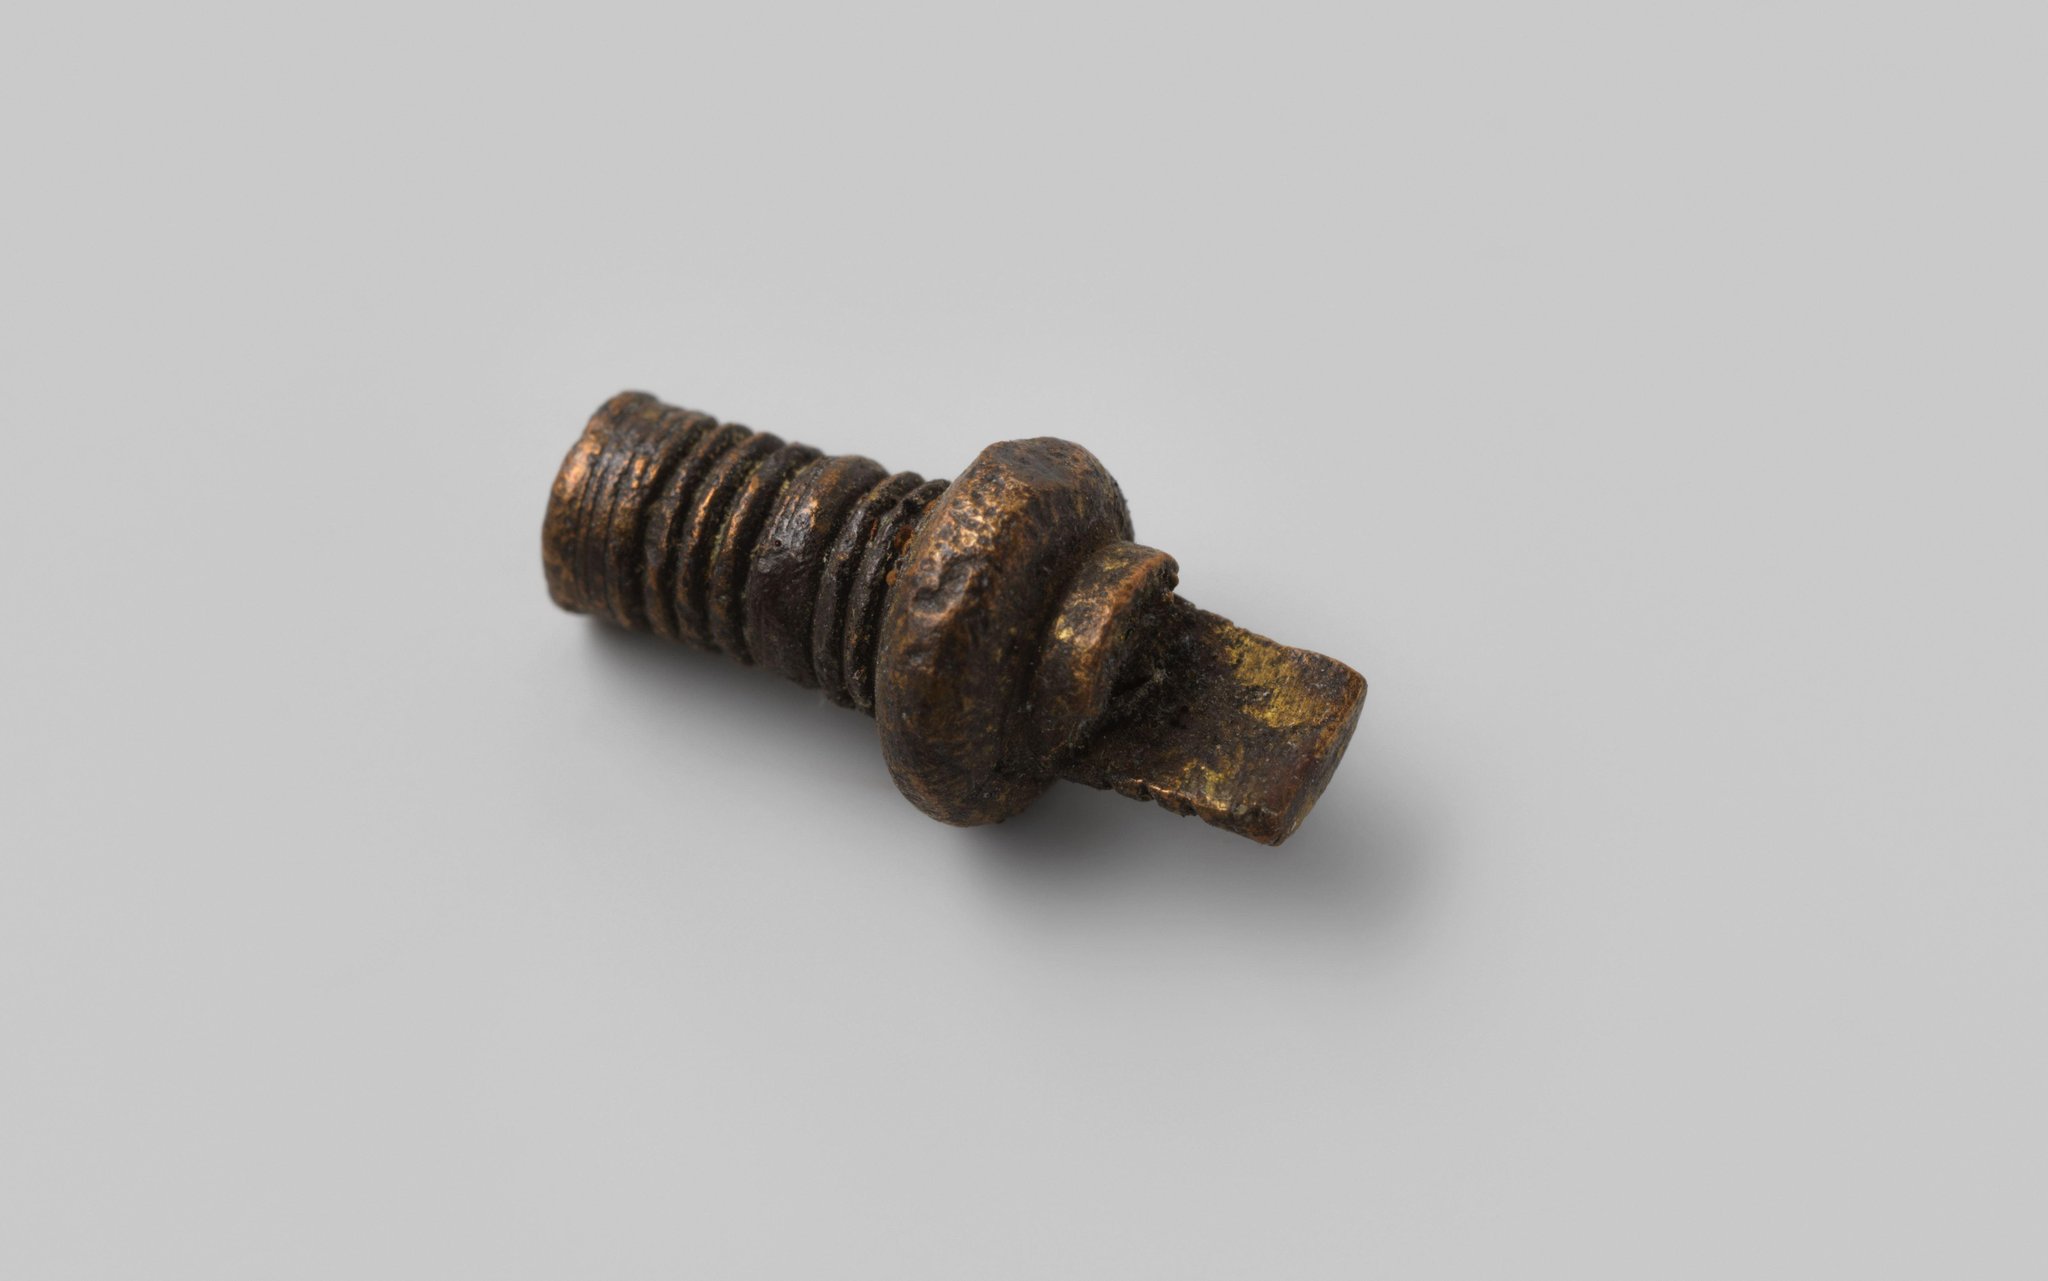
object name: helve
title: Fragment koperen steel uit het wrak van de Oost-Indiëvaarder Hollandia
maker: Anonymous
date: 1700-1743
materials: copper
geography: netherlands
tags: verenigde oostindische compagnie, hollandia (schip), annet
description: Varied parts or fragments, shafts; fragm, cylindrical, straight ends, ribbed, flattened knop in centre, one end with vertical slit, broken off.